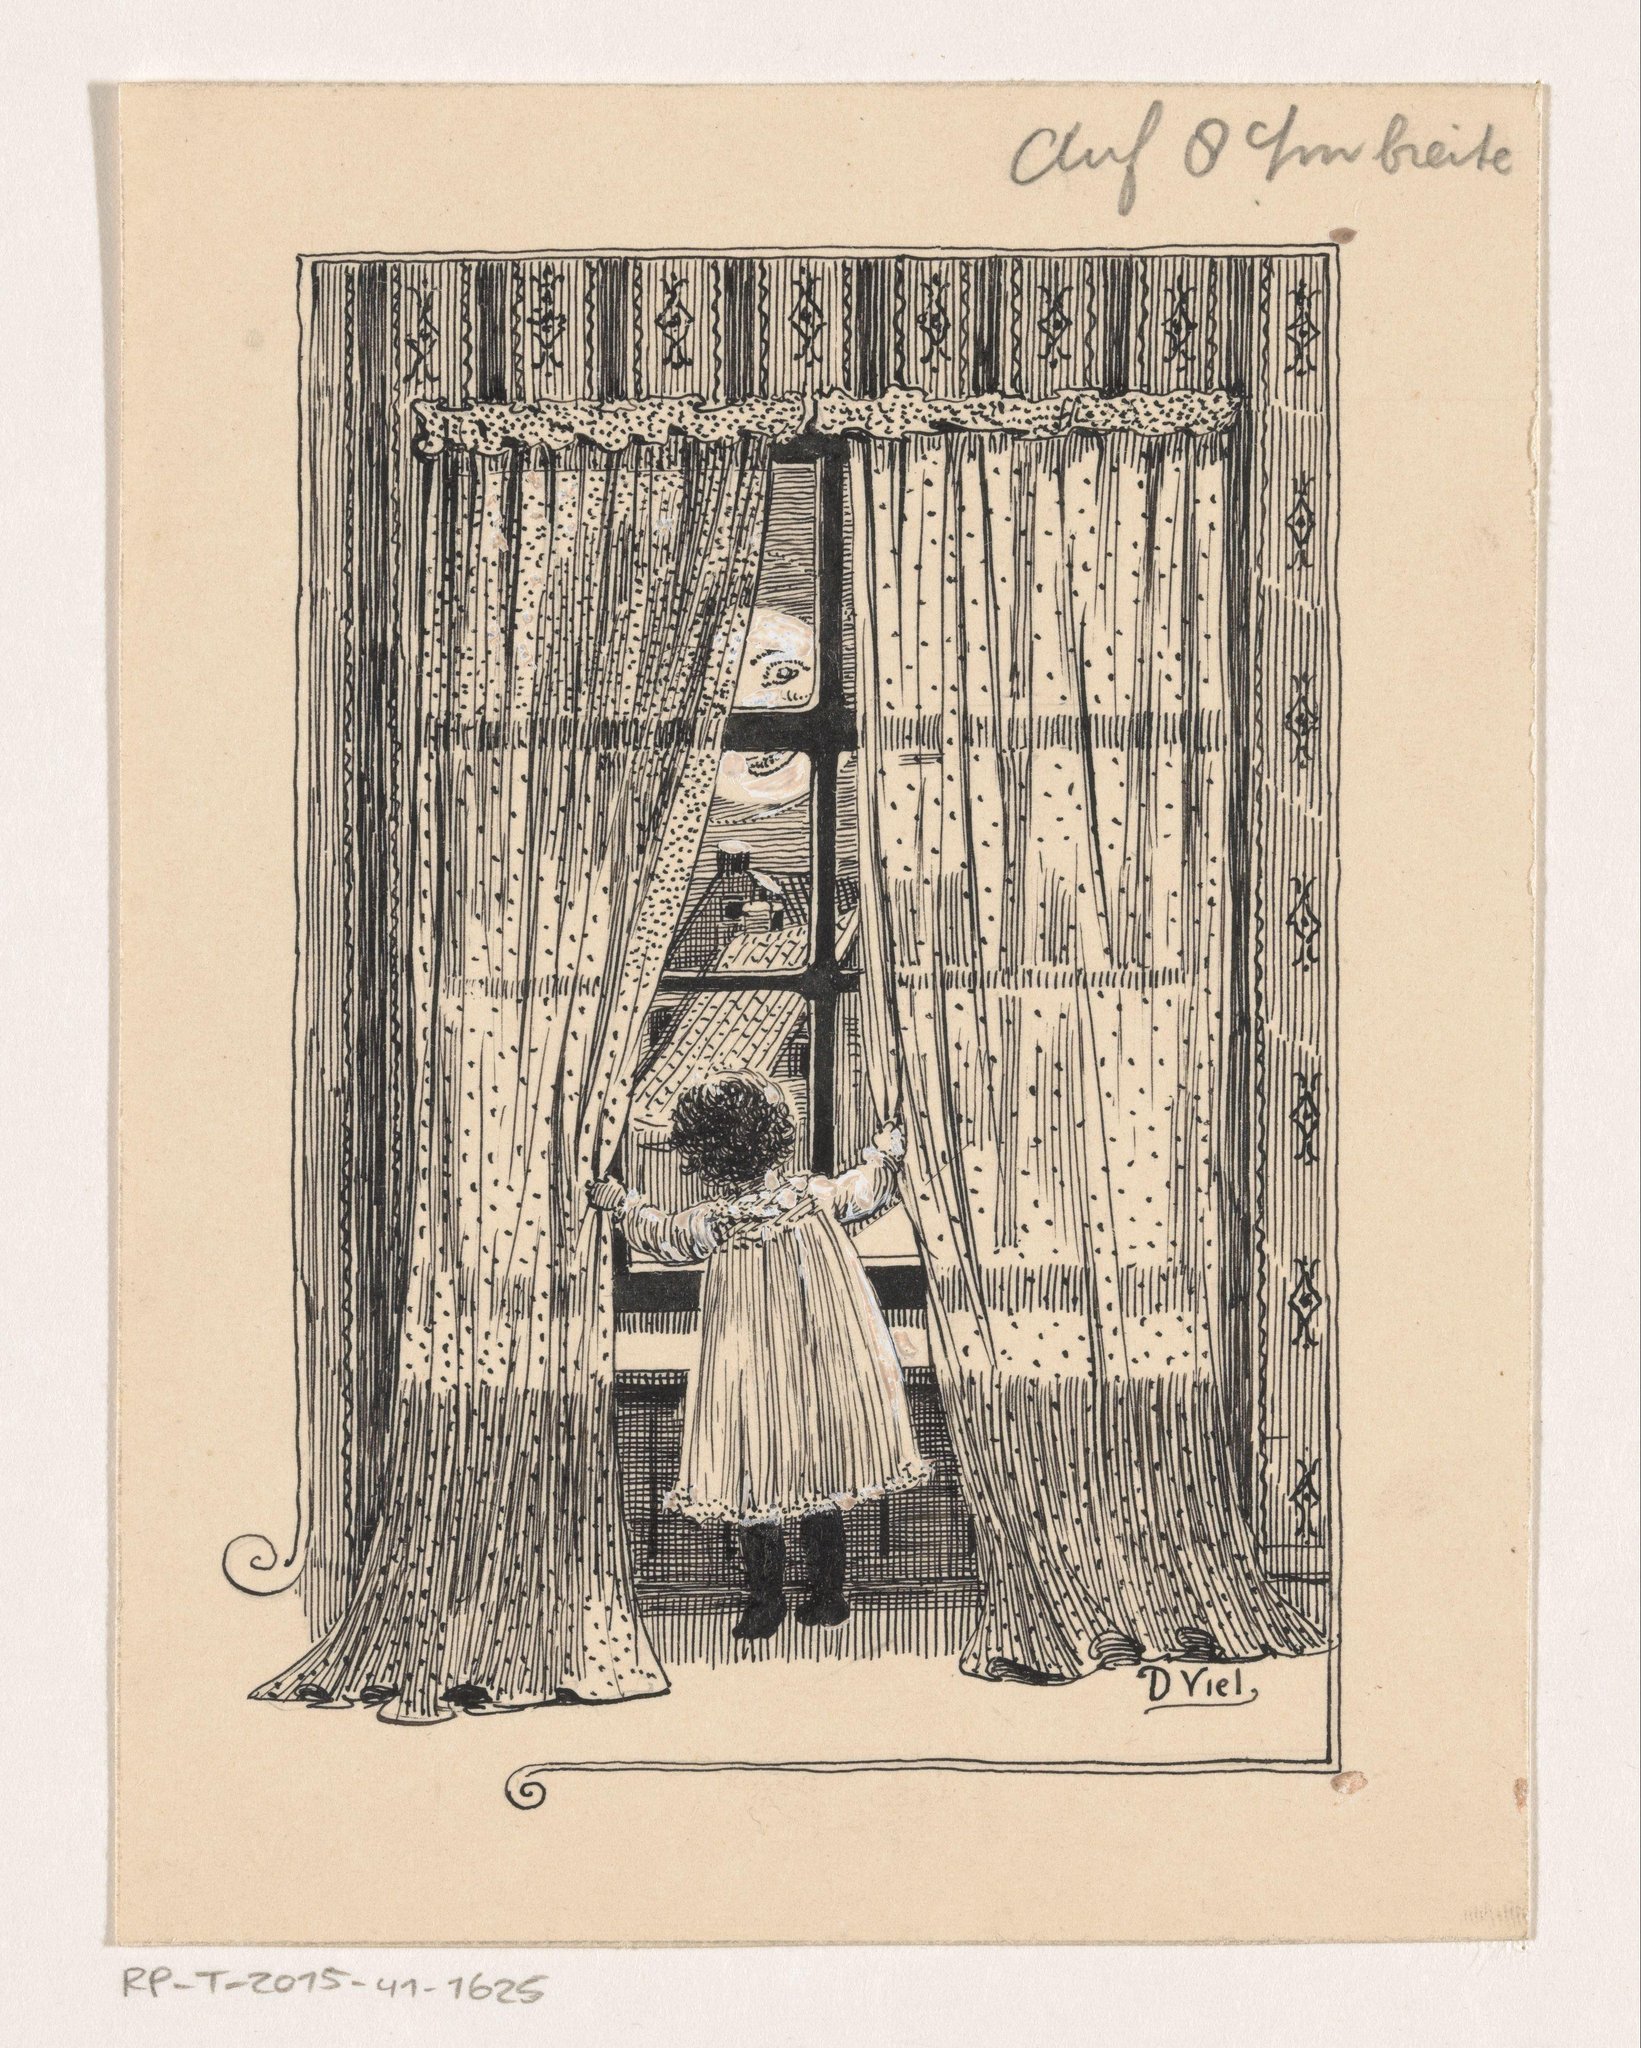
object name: boekillustratie ontwerp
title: Meisje kijkt naar de maan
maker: d. viel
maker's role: draughtsman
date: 1915-1935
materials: paint, ink, paper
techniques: brush, pen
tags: curtains, full moon represented as face, window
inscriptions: collector's mark: Lugt 2228, :, signature: ‘D Viel’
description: Een meisje staat tussen de gordijnen bij een raam. Ze kijkt door het raam naar buiten naar een volle maan die boven de daken schijnt.